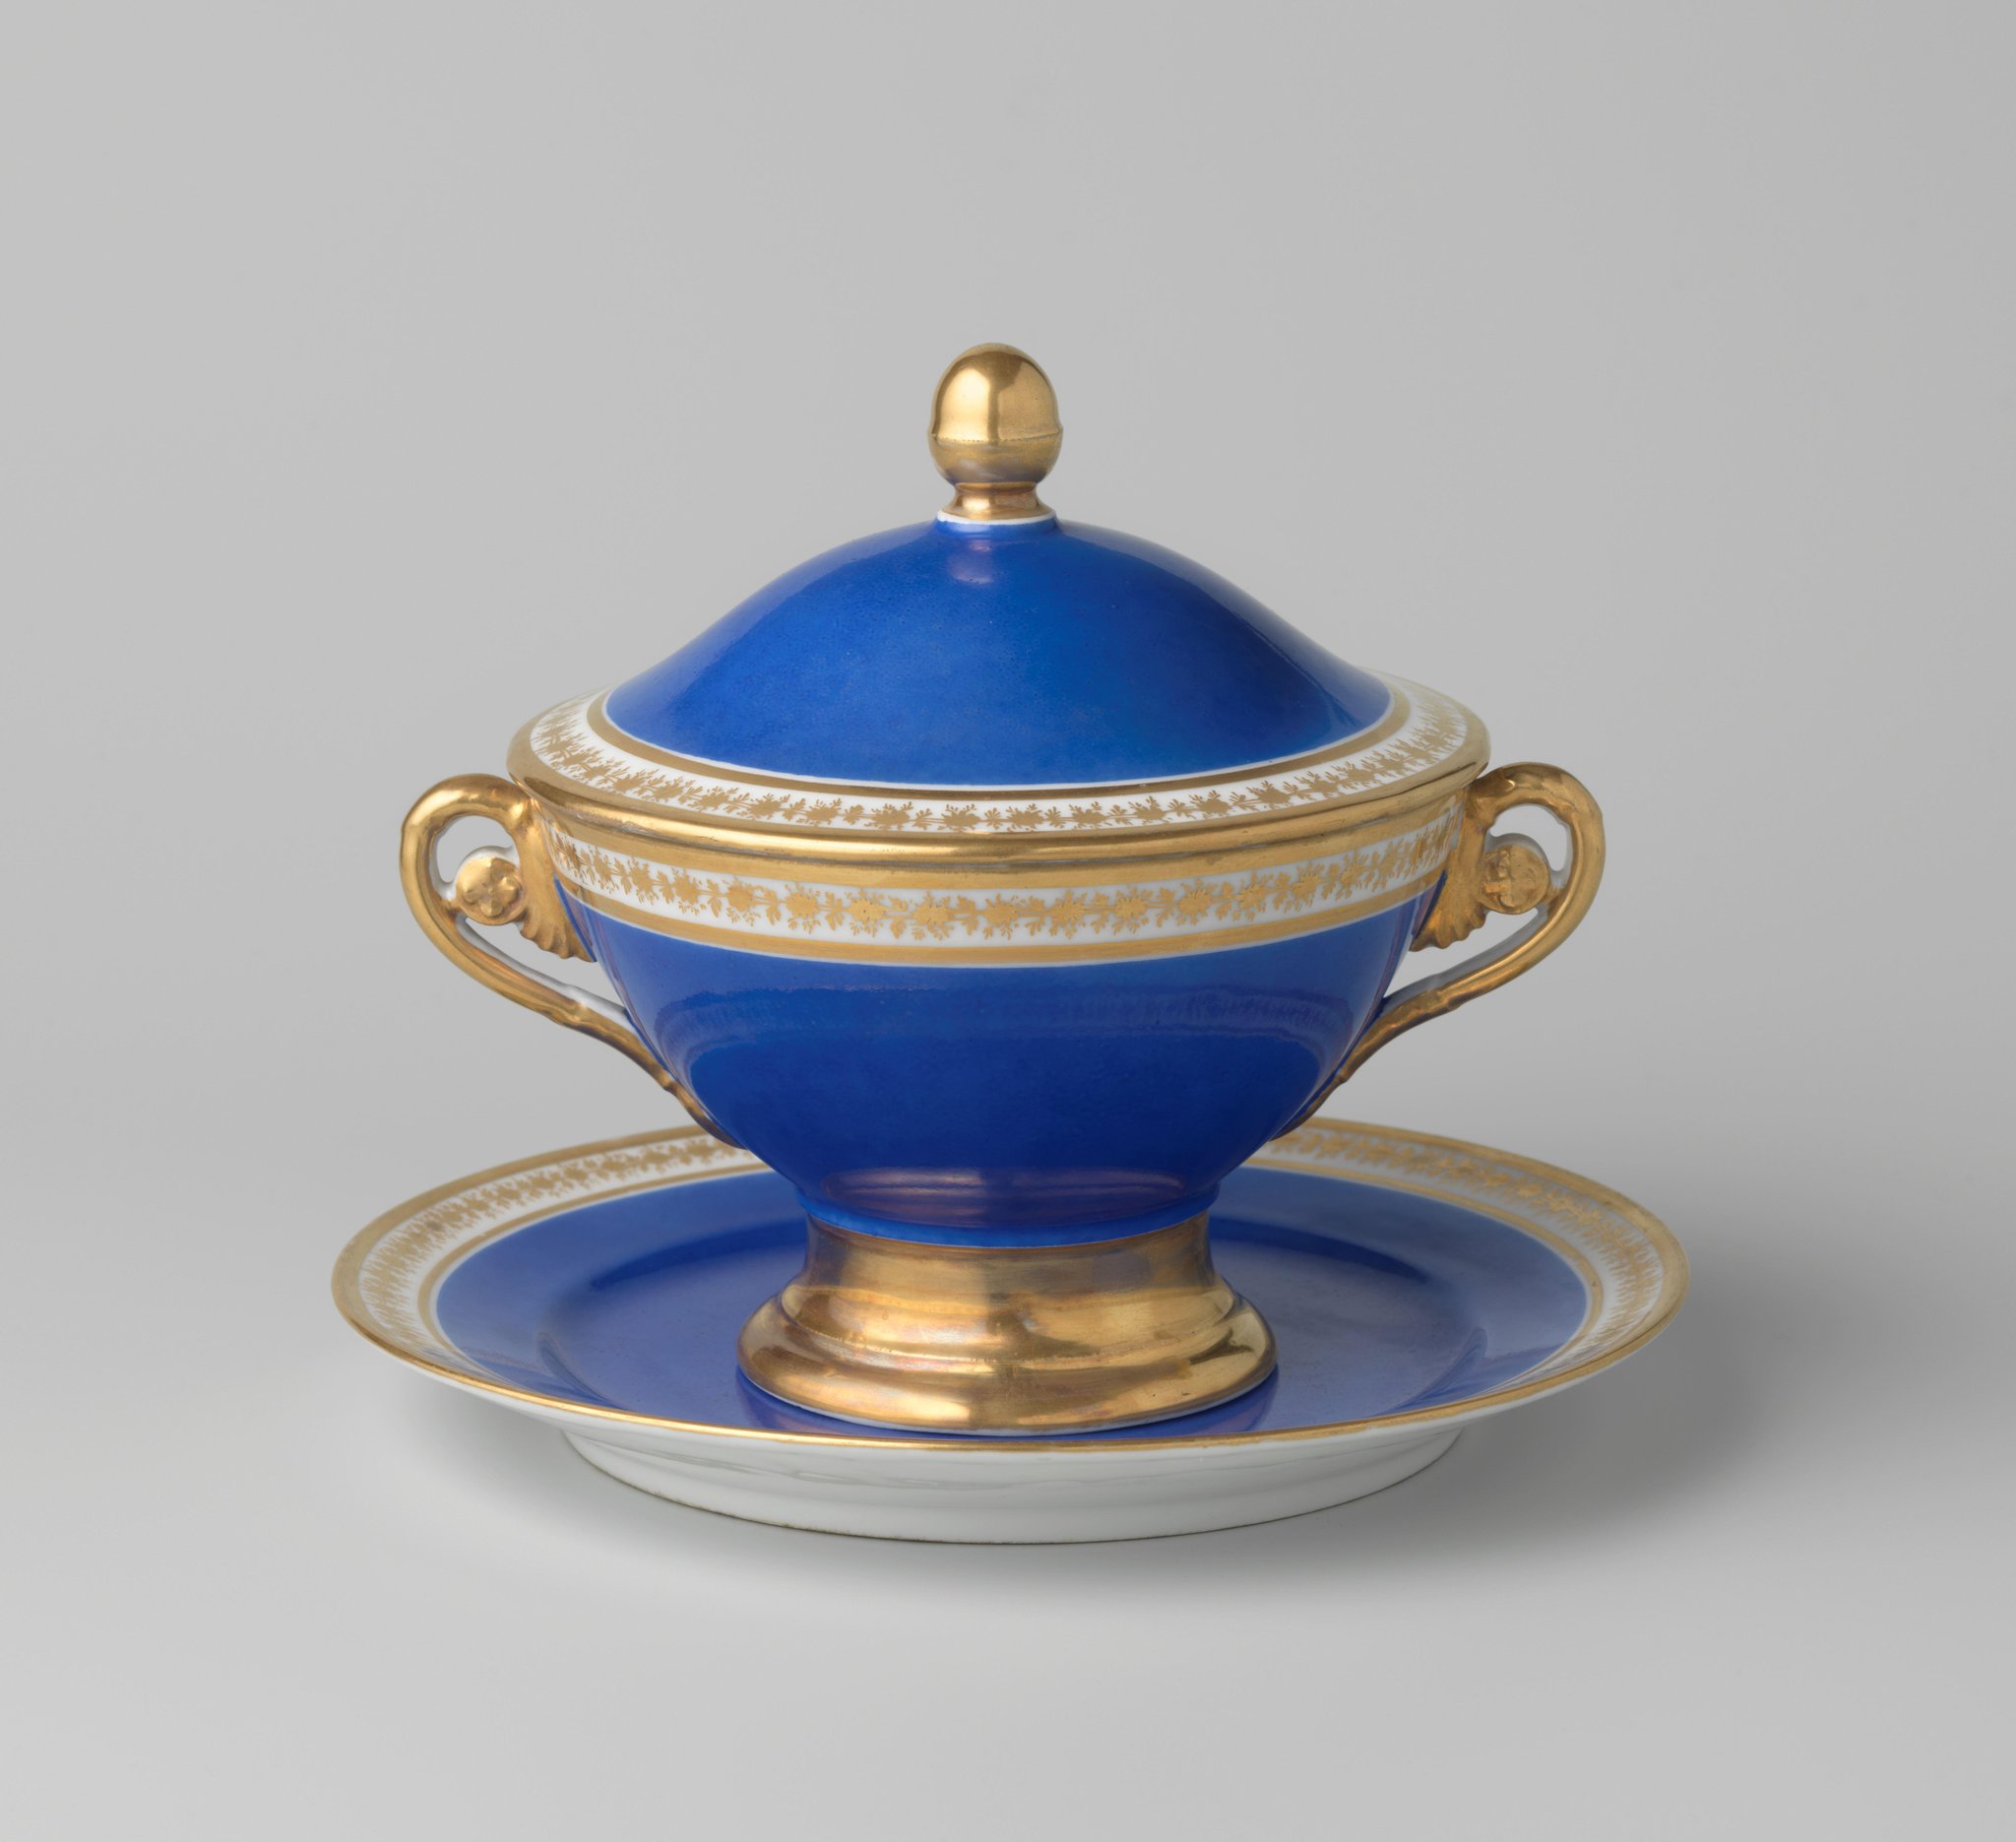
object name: lid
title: Cover of a tureen with blue and ornamental borders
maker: Anonymous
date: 1800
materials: glaze, gold, paint, porcelain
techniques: firing, forming, gilding, turning, vitrification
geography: france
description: Deksel van een terrine van porselein, beschilderd op het glazuur in blauw en goud. De deksel is bedekt met blauw, met uitgespaard op de rand een band met een bloemrank.